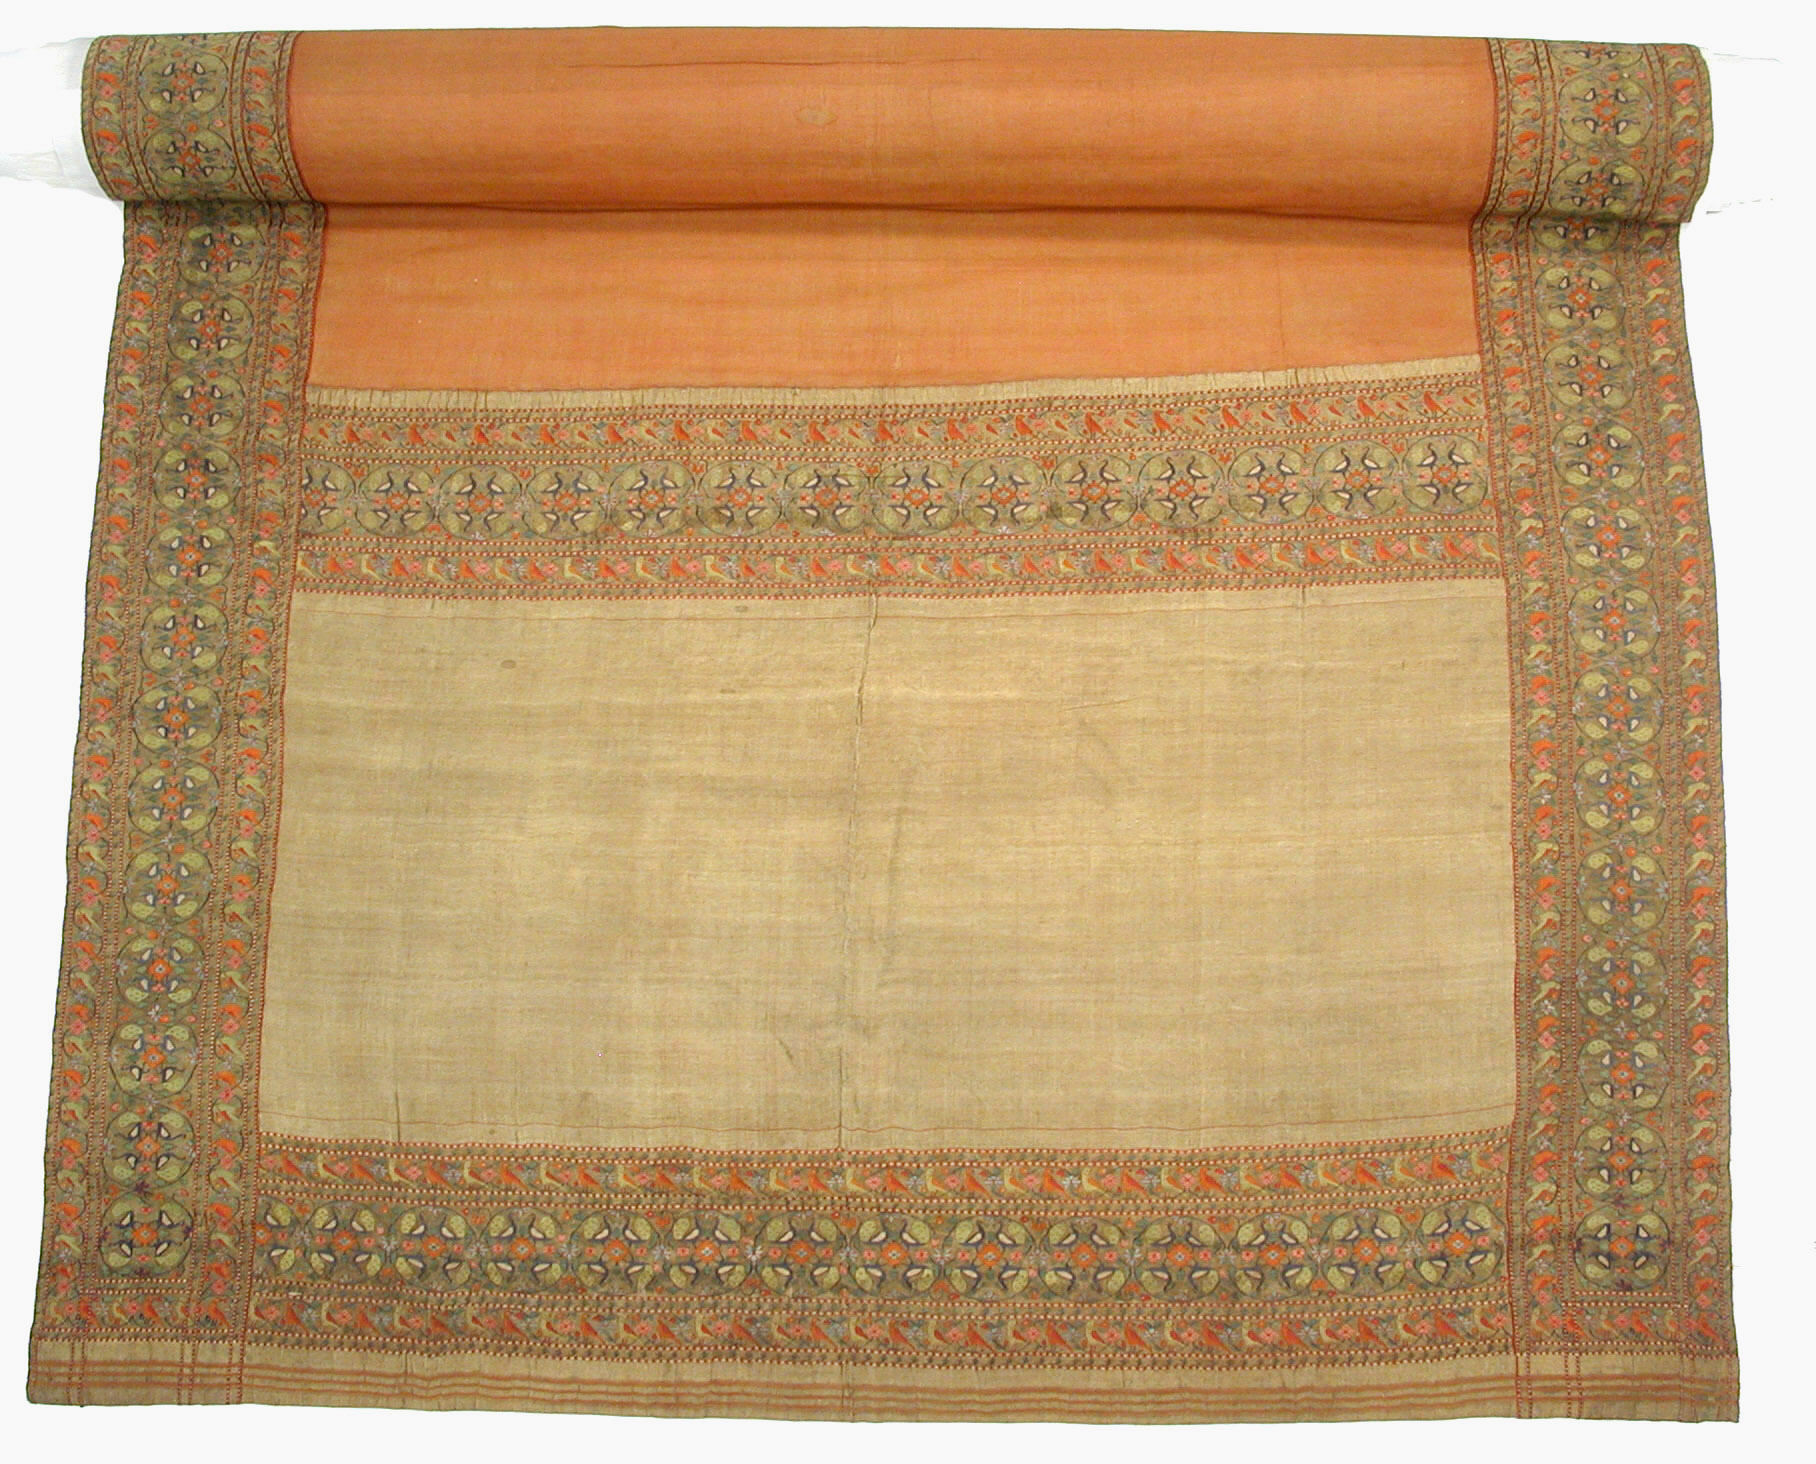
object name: shawl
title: Shawl (Chaddar)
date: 1701-1800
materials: metal thread, silk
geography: india